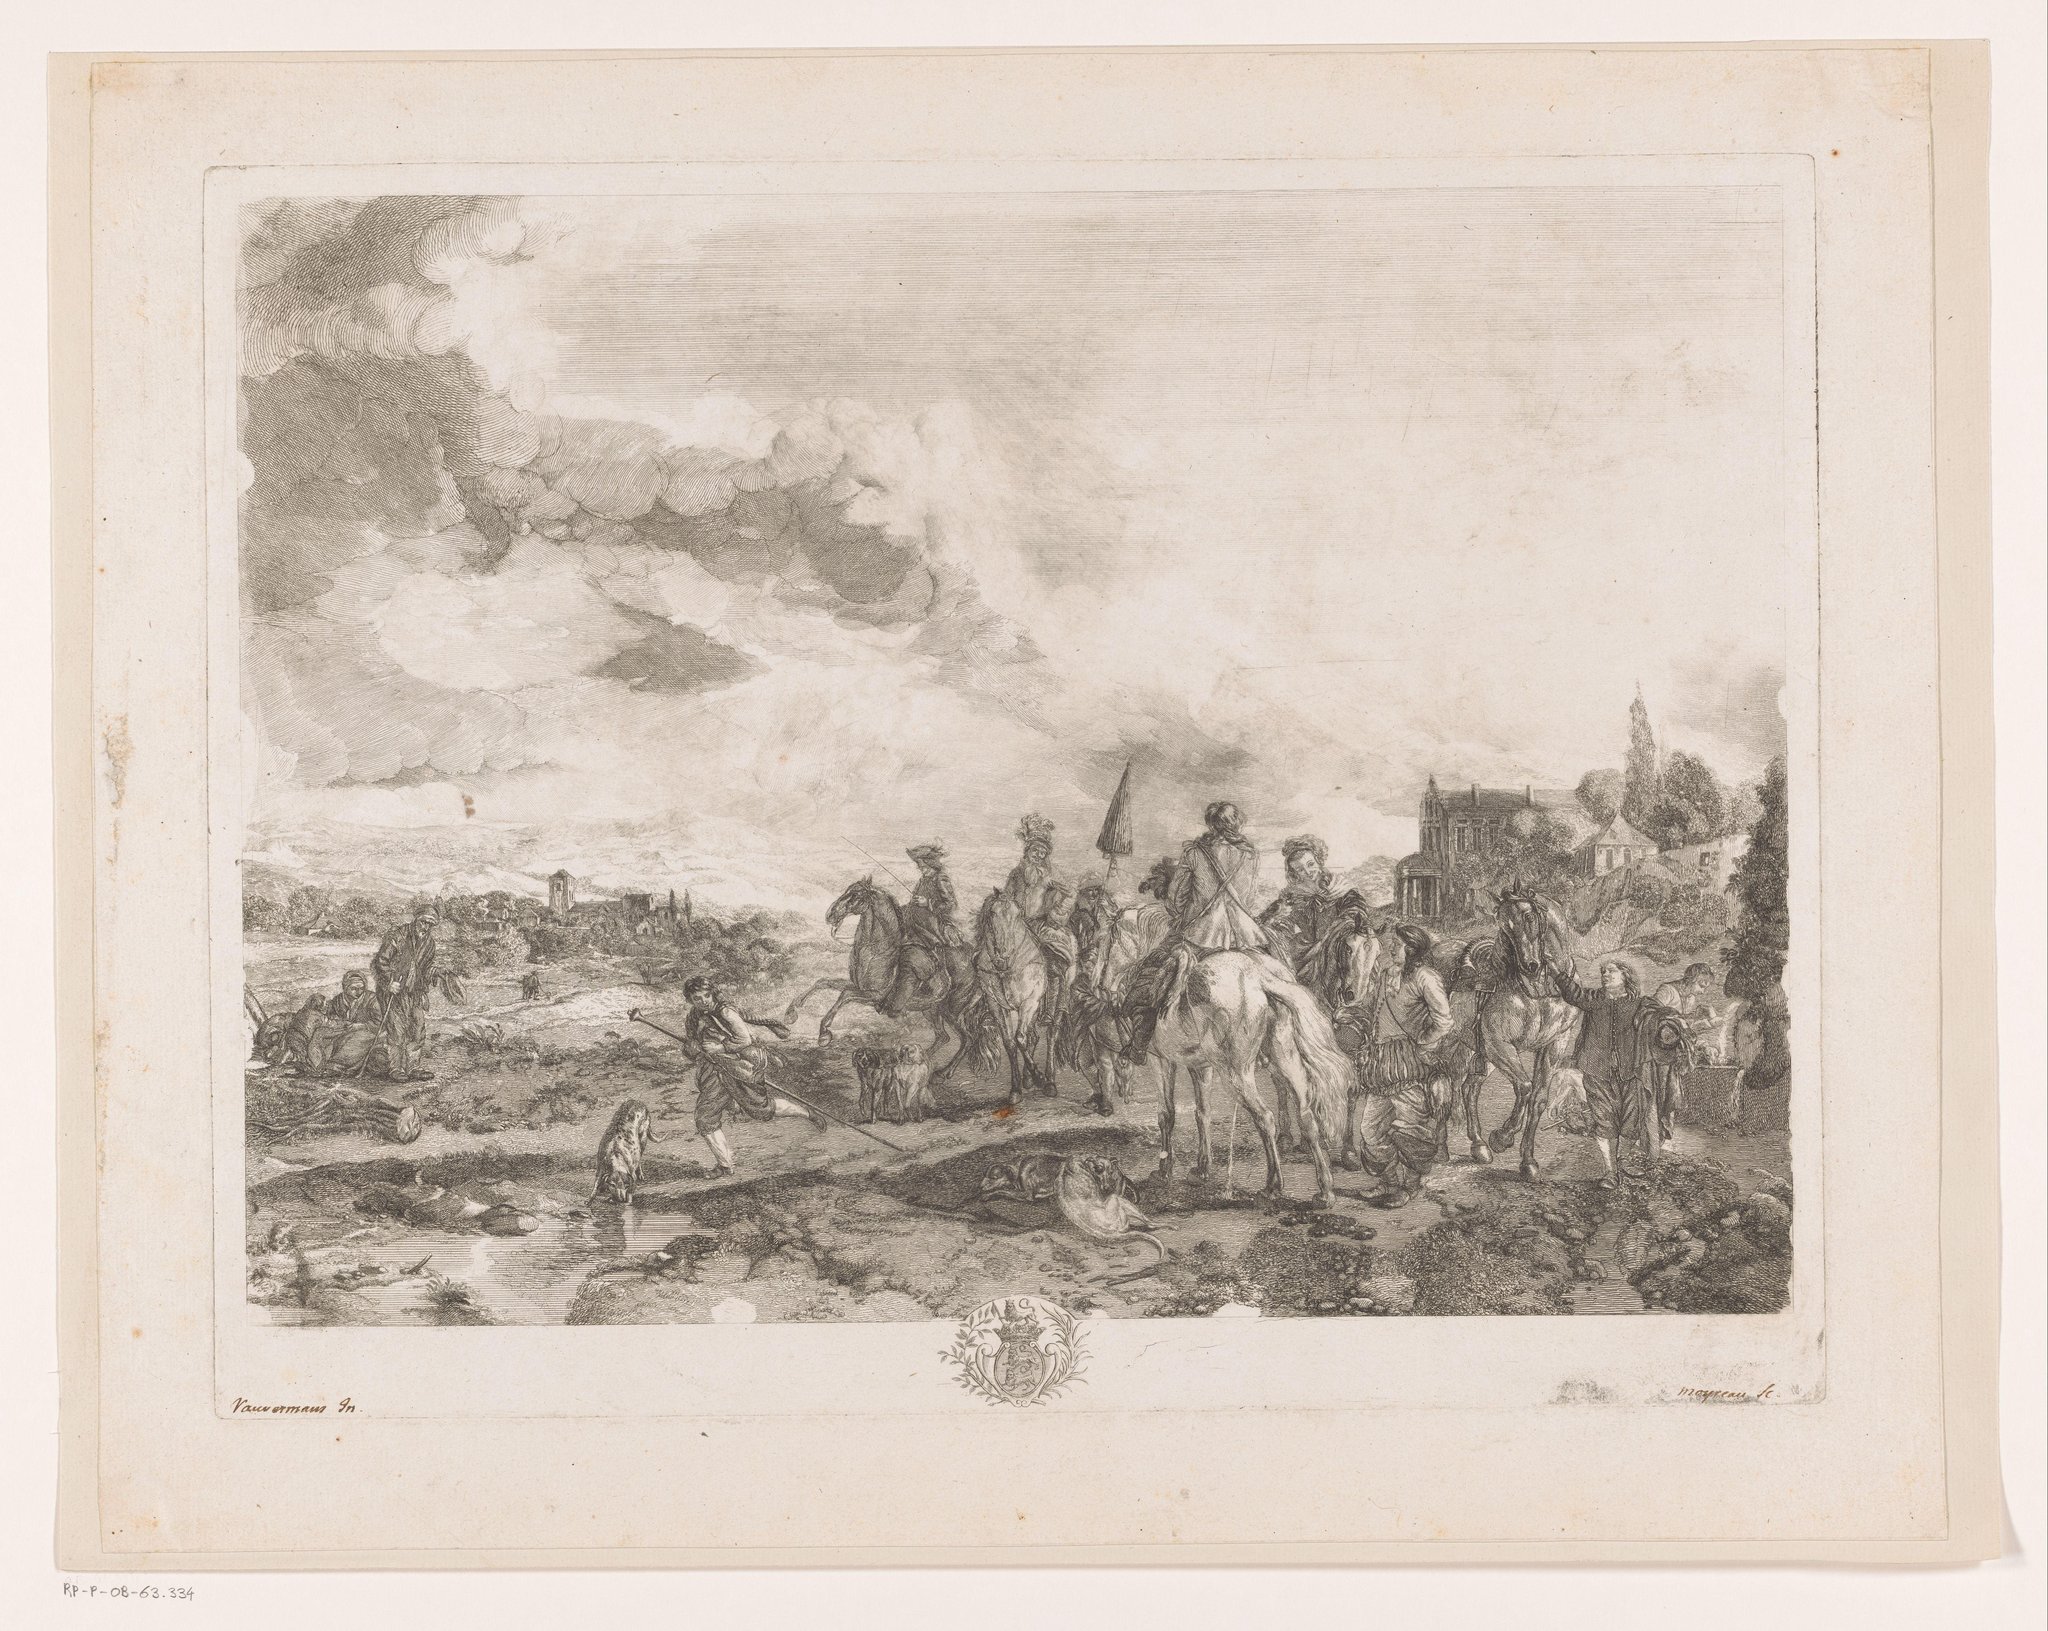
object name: print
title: Prenten naar schilderijen door Philips Wouwerman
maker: jean moyreau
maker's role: print maker, publisher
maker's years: 1690-1762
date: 1751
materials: paper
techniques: etching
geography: france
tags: hunters resting during the hunt, assembling, 'départ pour la chasse'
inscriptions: collector's mark: Lugt 240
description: Maakt deel uit van een serie van 89 prenten te dateren tussen ca. 1733-1762, naar het geschilderde oeuvre van Philips Wouwerman. Dit betreft plaat 67.